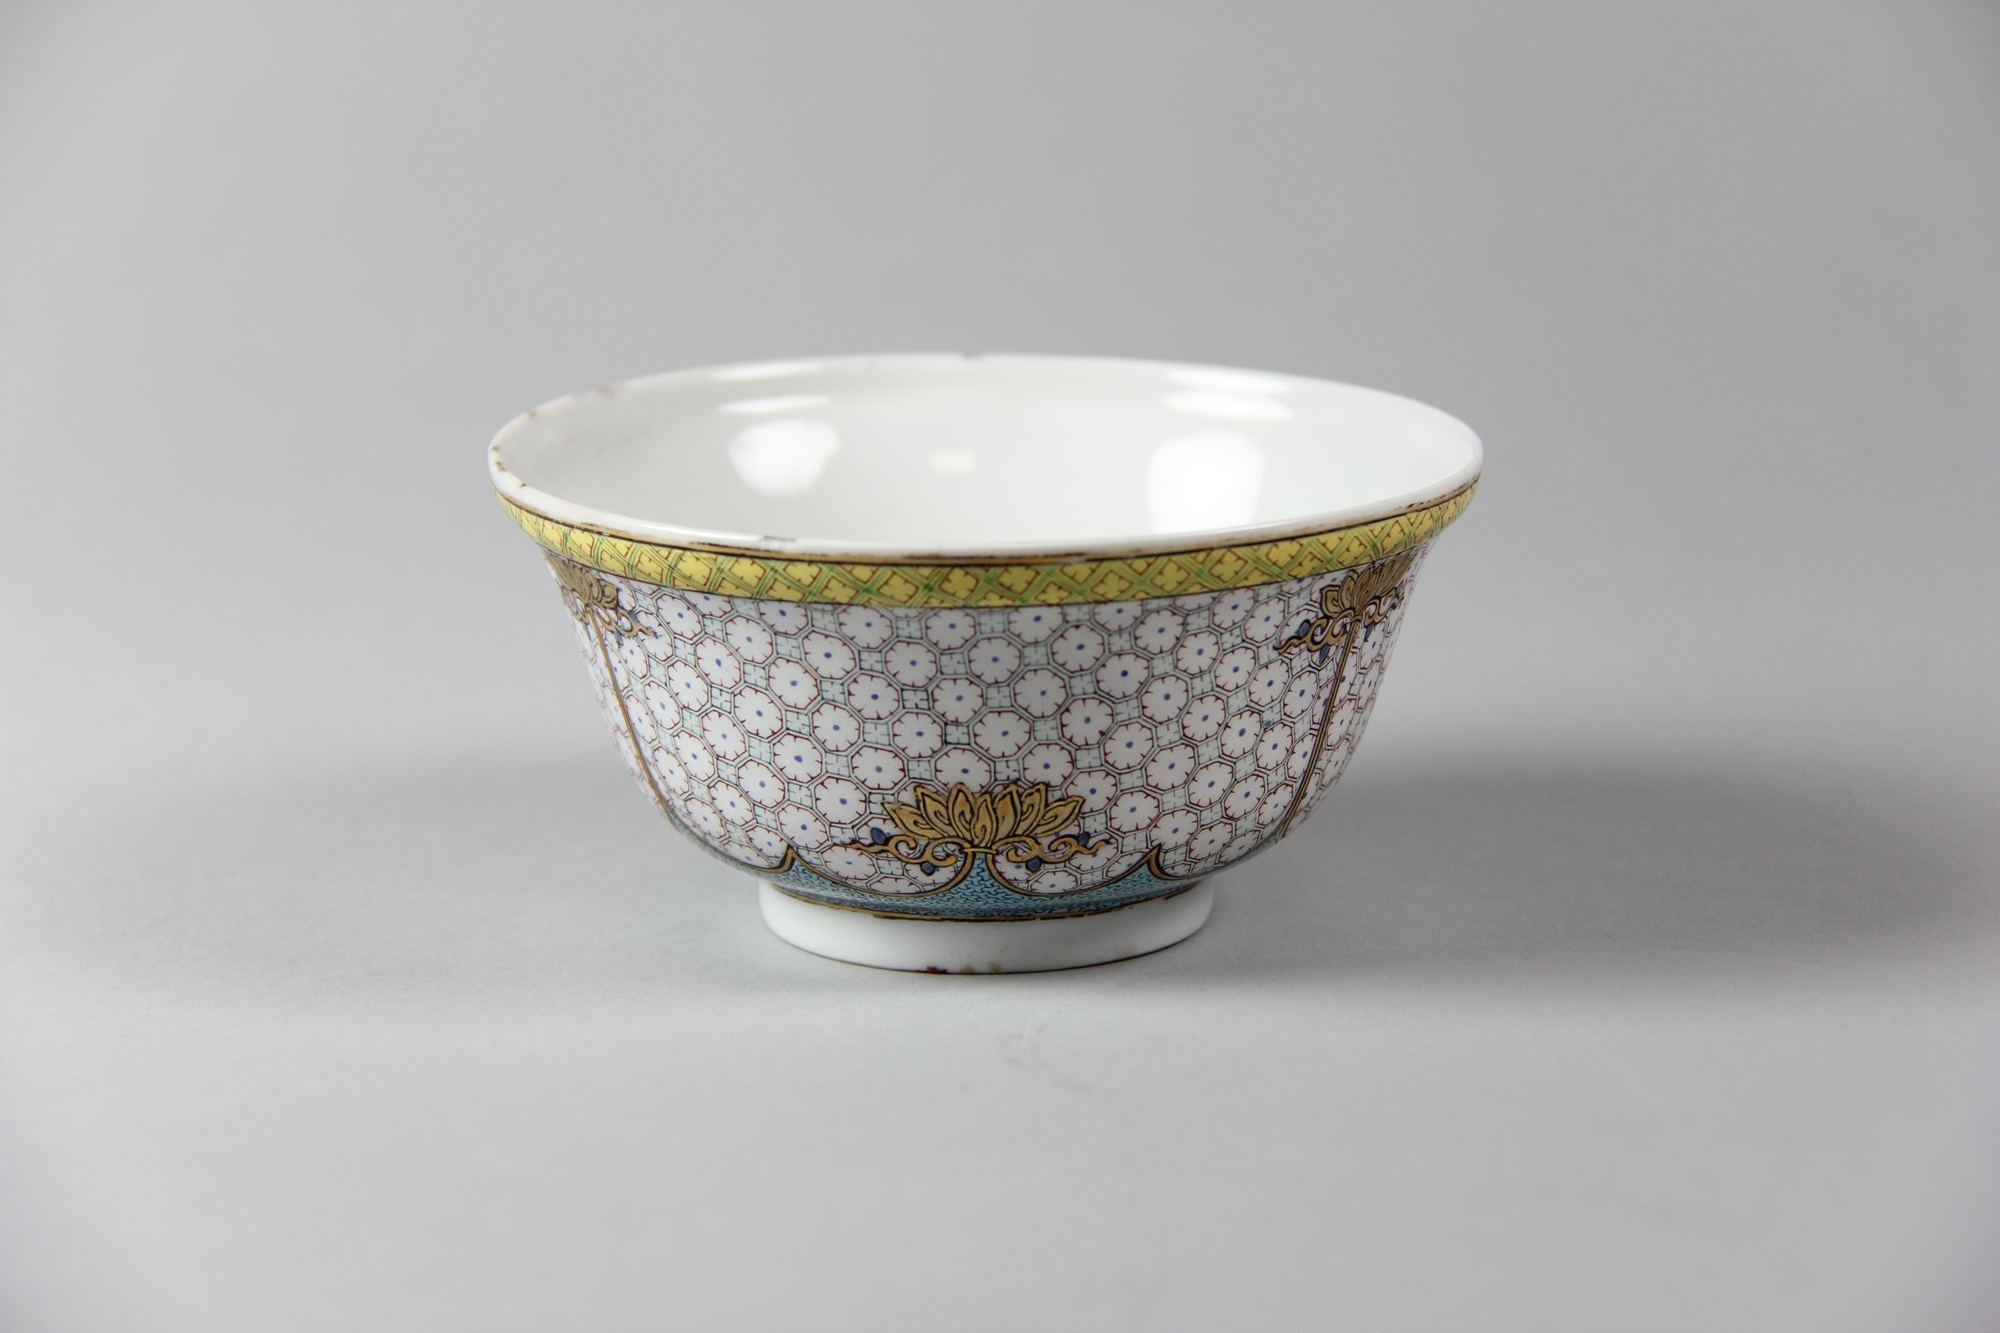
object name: bowl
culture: chinese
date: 1730-1750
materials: enamel, porcelain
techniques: overglaze, painting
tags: flowers